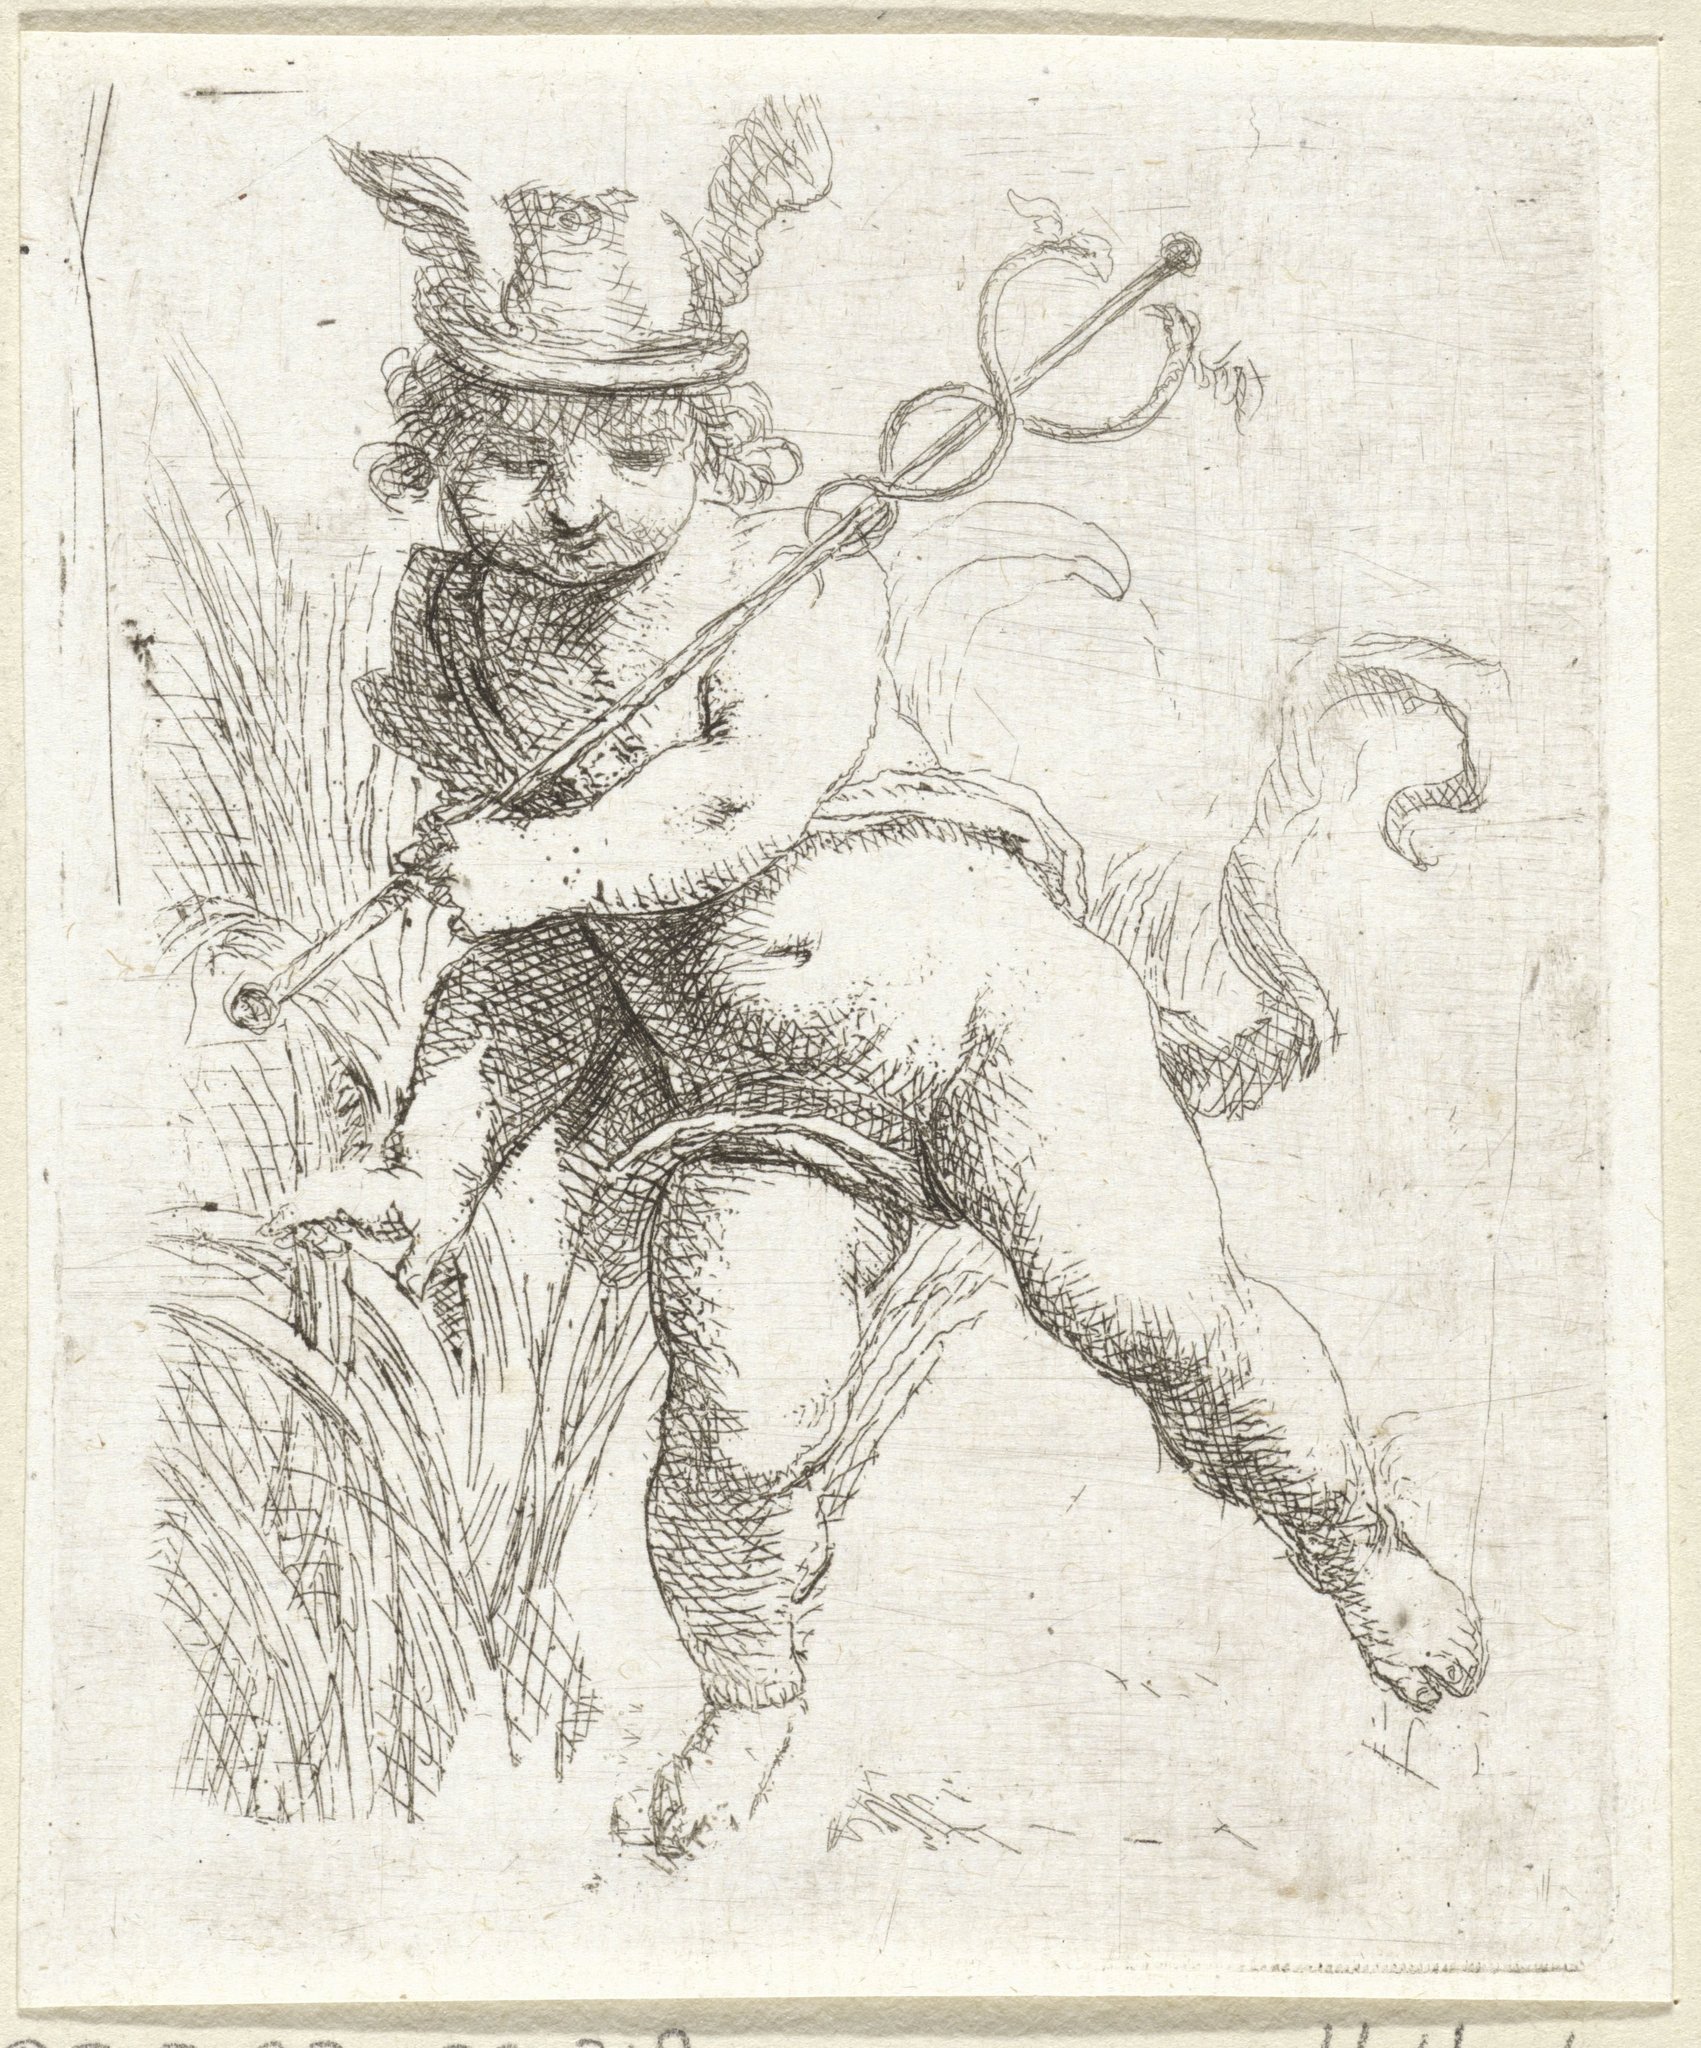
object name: print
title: Putto als Mercurius, met gevleugelde helm en caduceus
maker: cornelis schut (i)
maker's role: draughtsman, print maker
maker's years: 1597-1655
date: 1618-1655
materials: paper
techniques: engraving, etching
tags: (story of) mercury (hermes)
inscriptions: collector's mark: Lugt 240